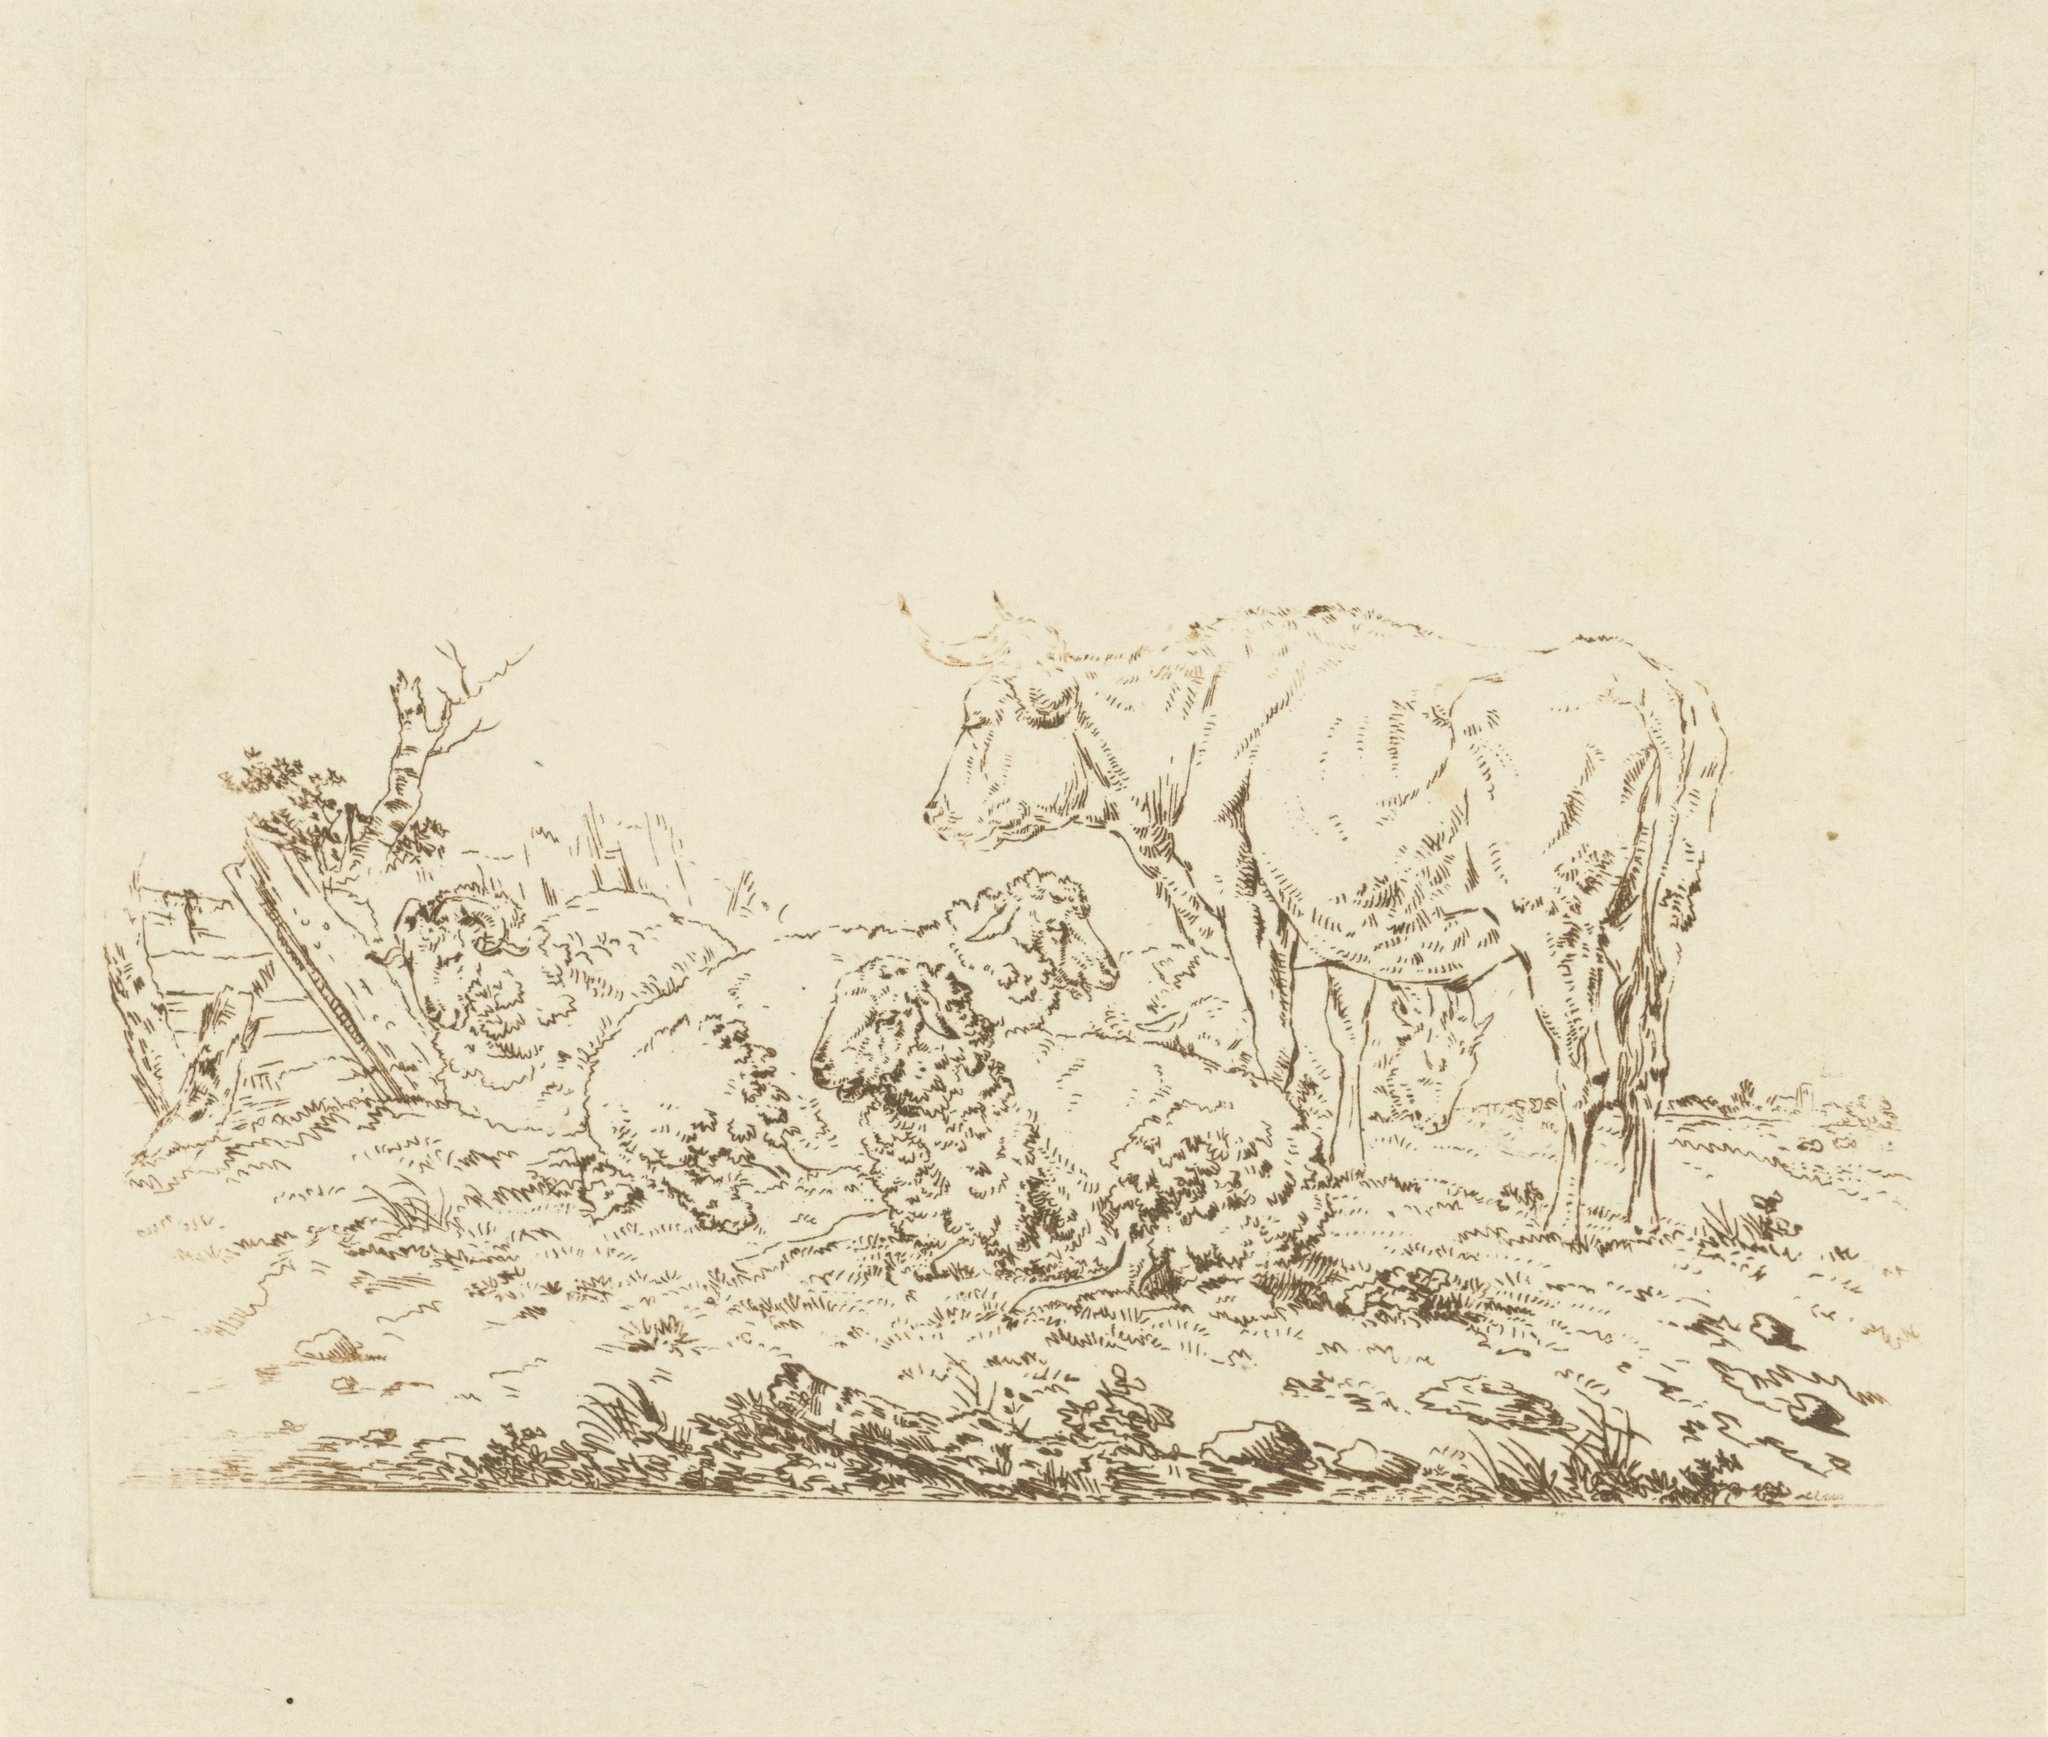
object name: print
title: Weiland met koe en schapen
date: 1811-1839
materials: paper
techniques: etching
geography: rotterdam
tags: meadow, pasture - hh - ideal landscapes, cow, ram, sheep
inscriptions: collector's mark: Lugt 2228